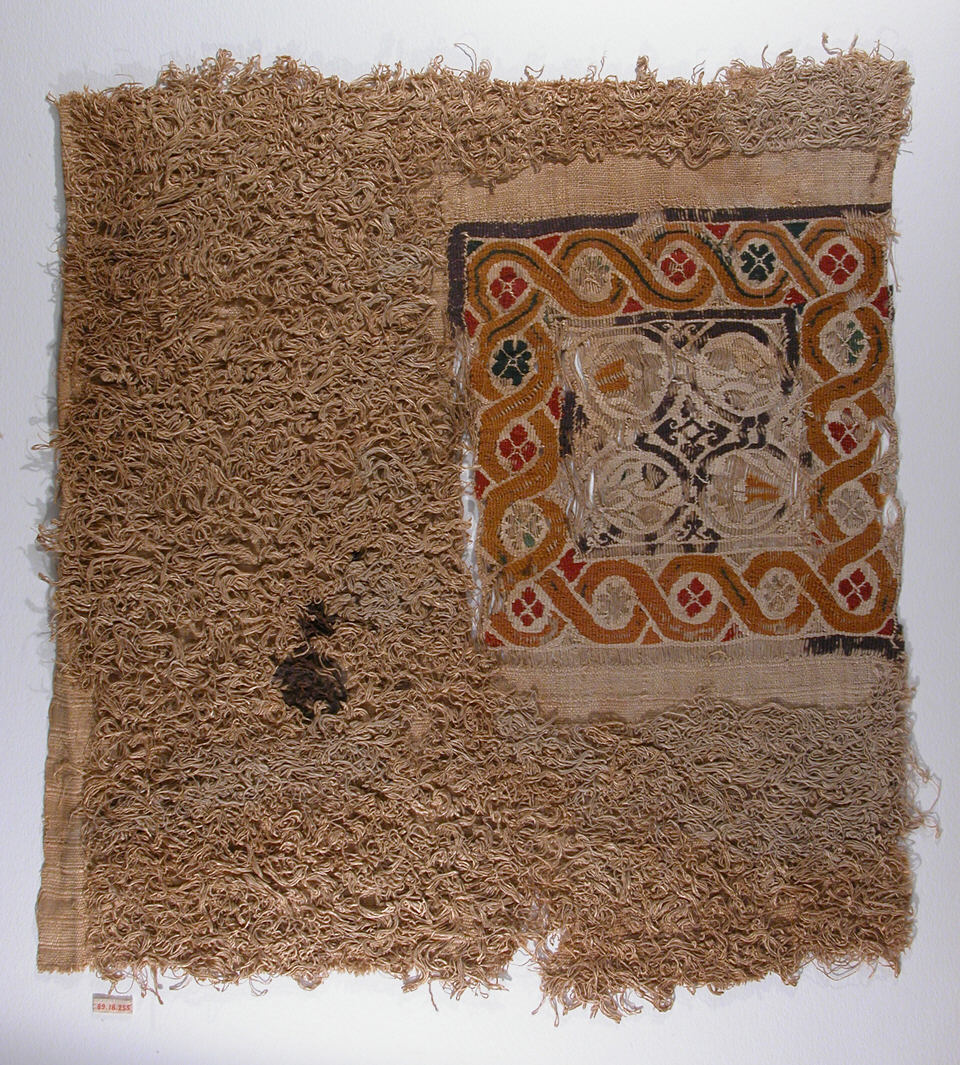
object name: textile fragment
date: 301-400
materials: linen, wool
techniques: weave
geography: egypt